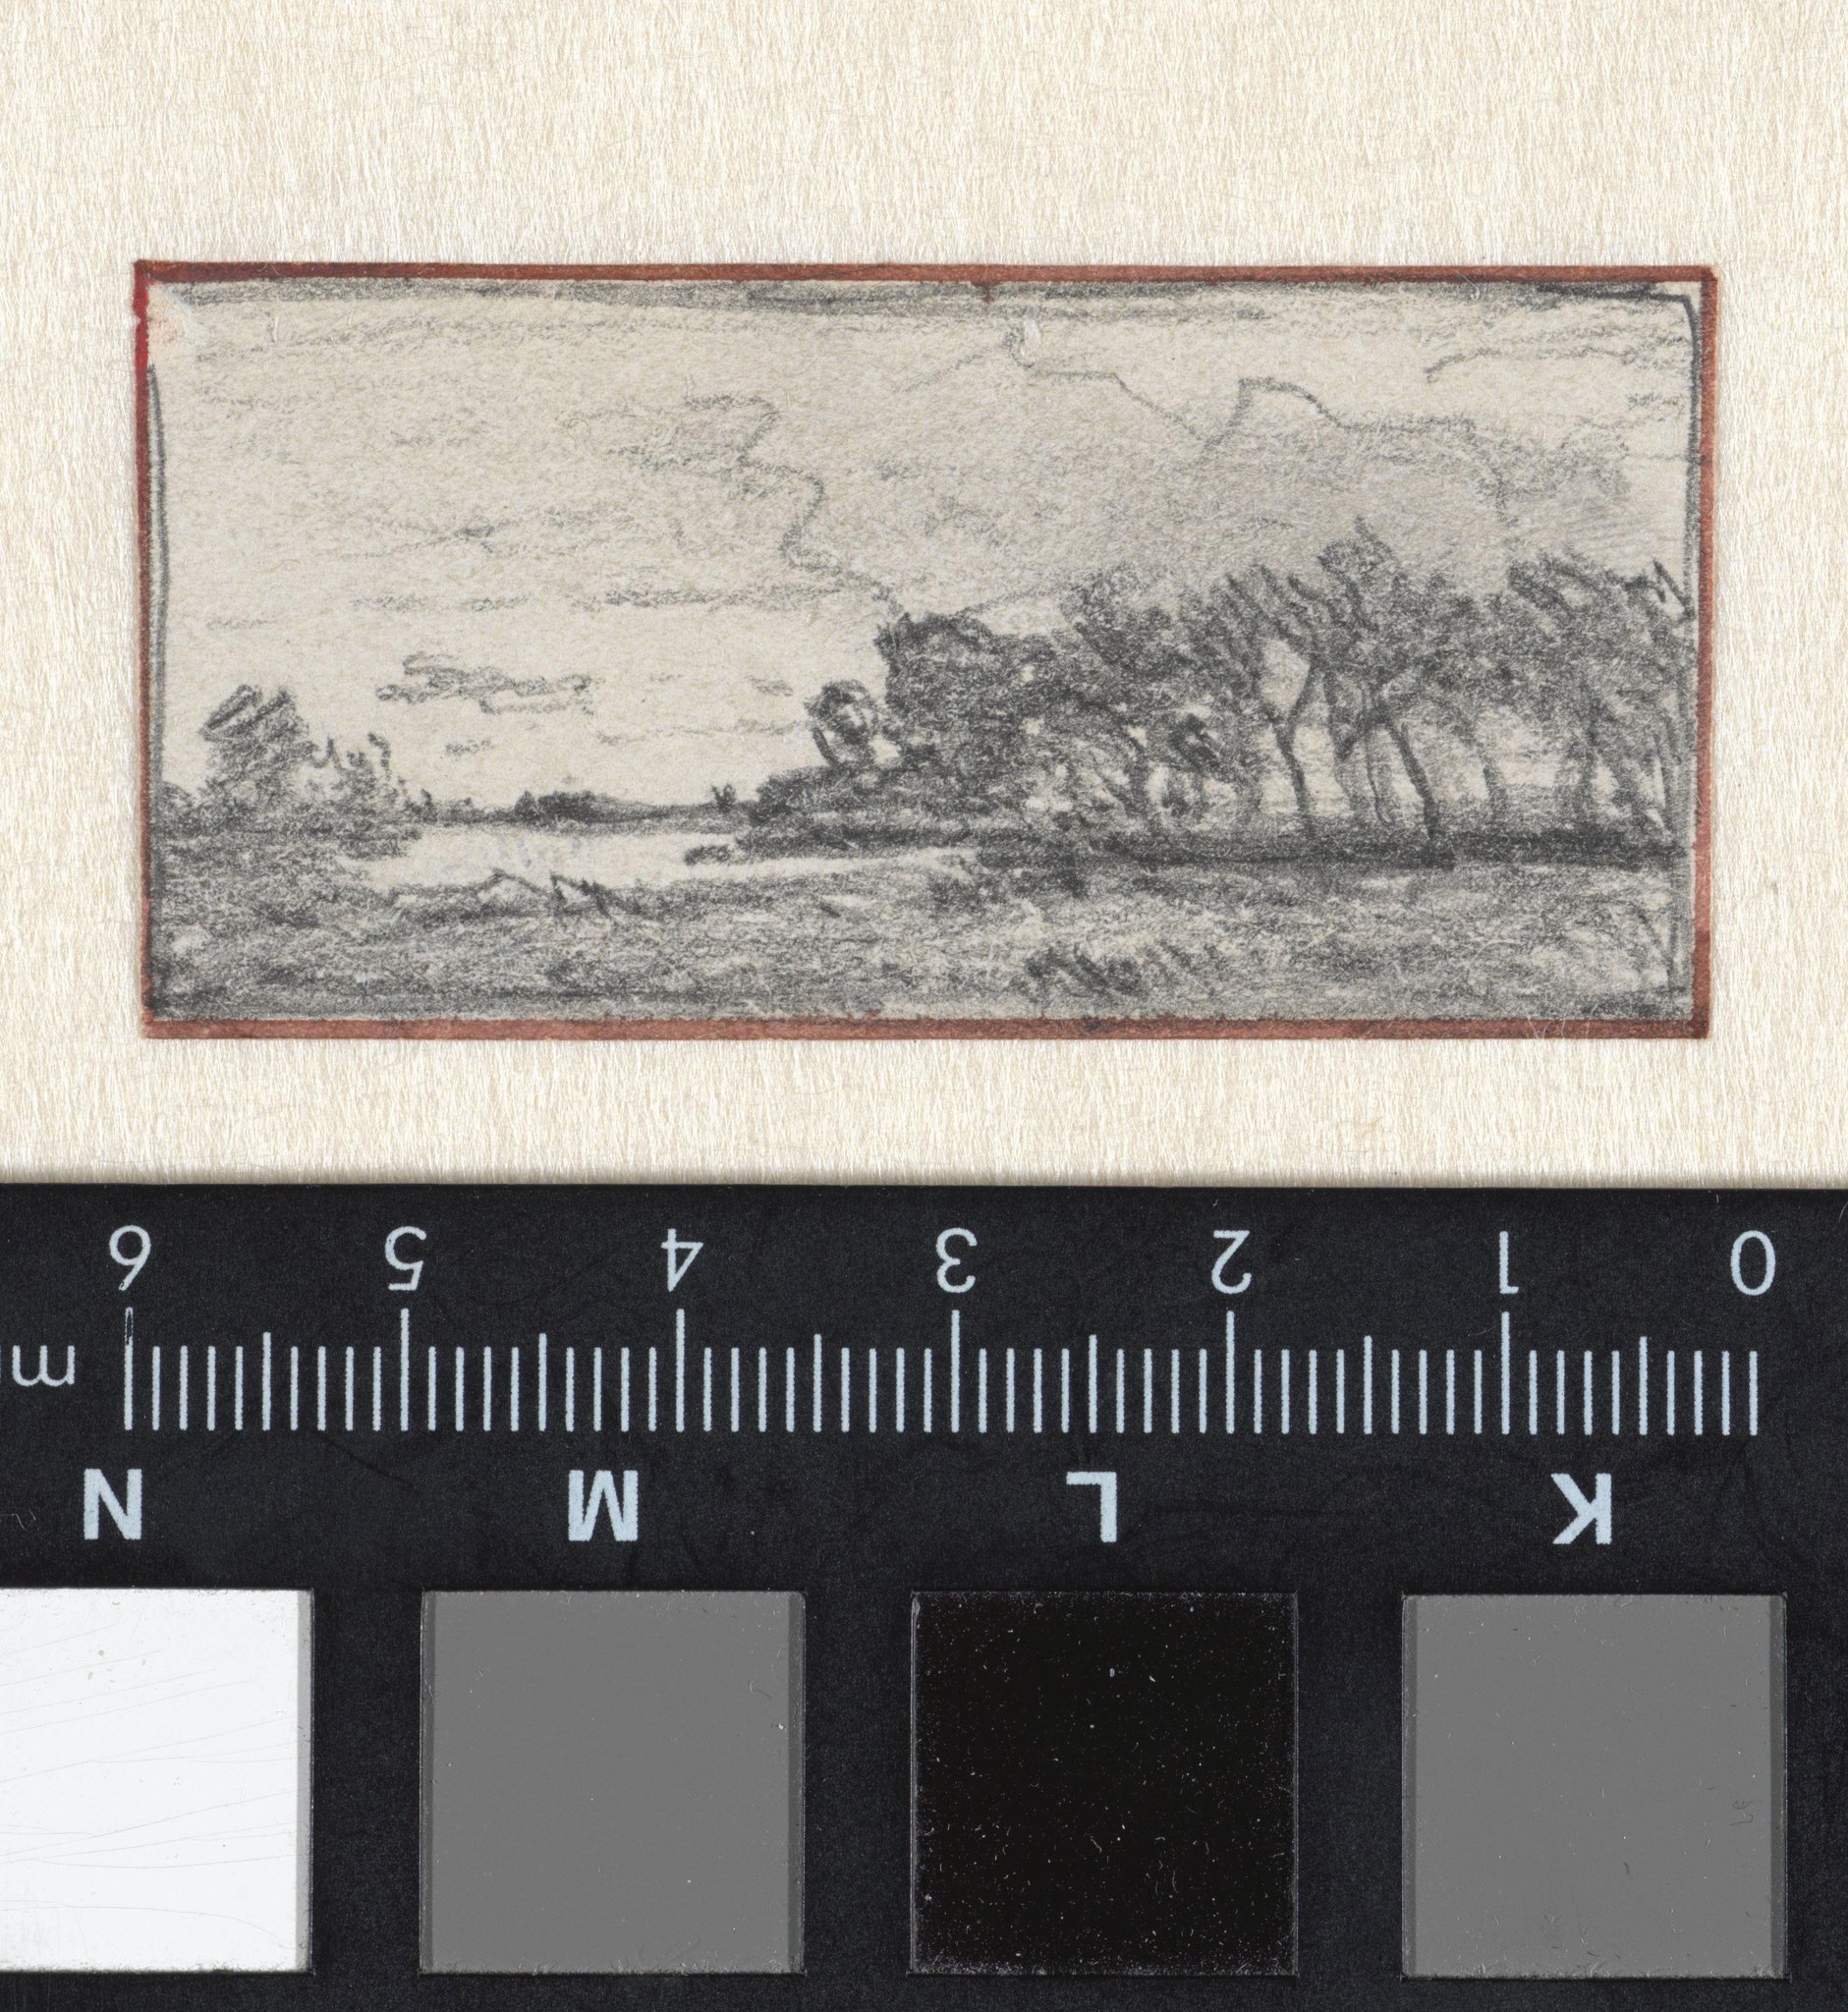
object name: drawing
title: Schets van een landschap met bossage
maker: willem roelofs (i)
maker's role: draughtsman, painter, print maker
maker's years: 1822-1897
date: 1832-1897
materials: paper, pencil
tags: landscapes with waters, waterscapes, seascapes (in the temperate zone)